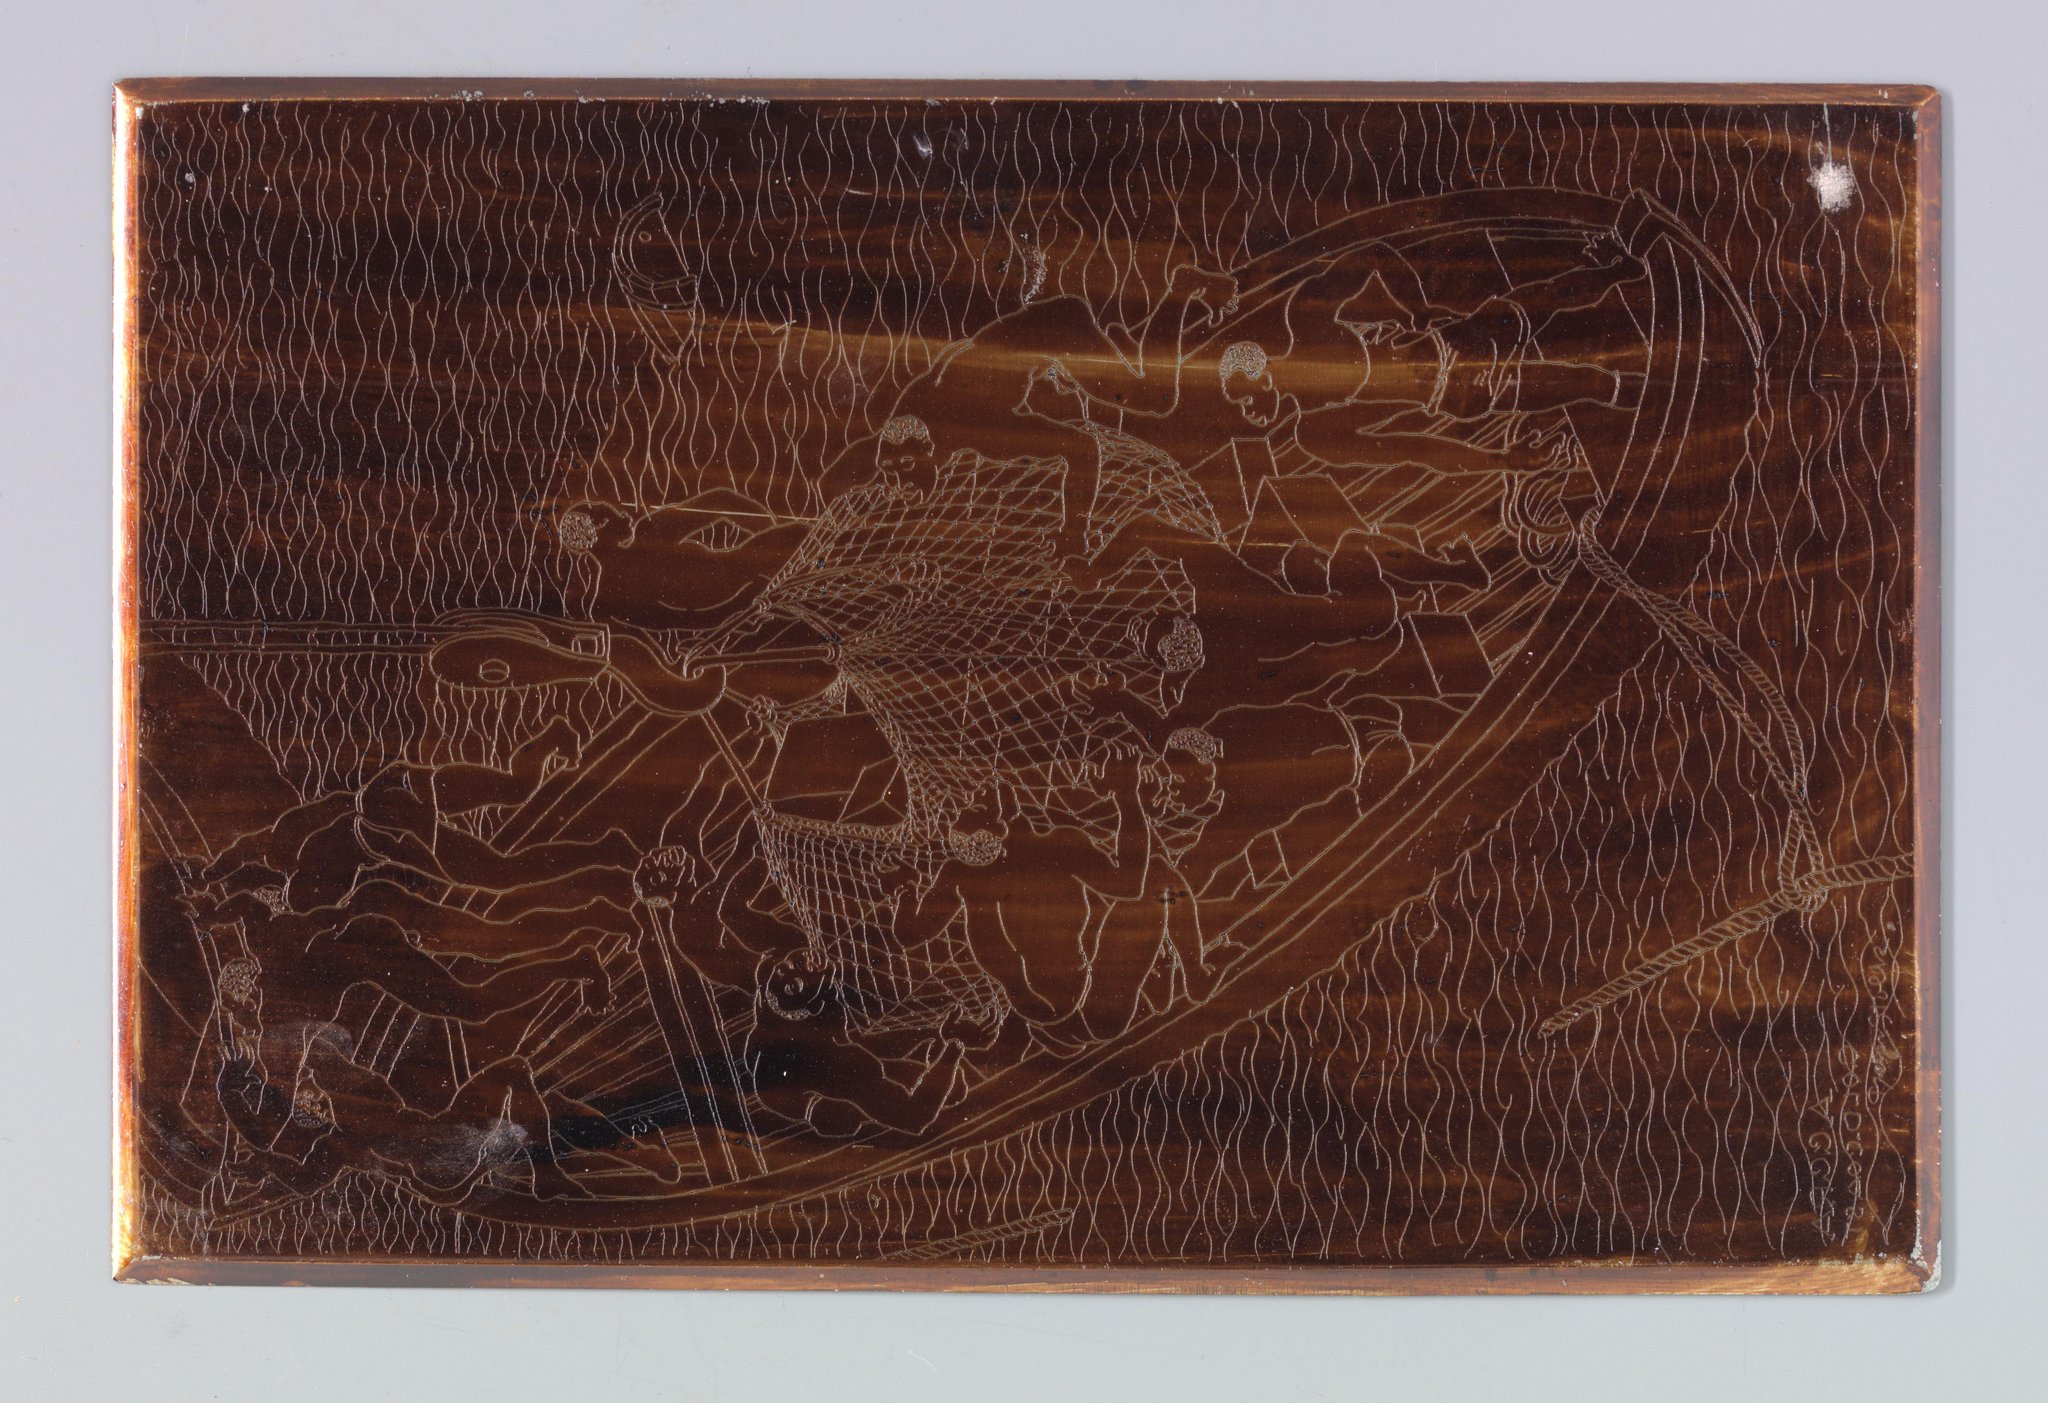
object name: zinkplaat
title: Figuren in een prauw met een net vol bagage te Accra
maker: reijer stolk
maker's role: draughtsman, print maker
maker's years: 1896-1945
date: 1906-1945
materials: zinc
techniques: etching